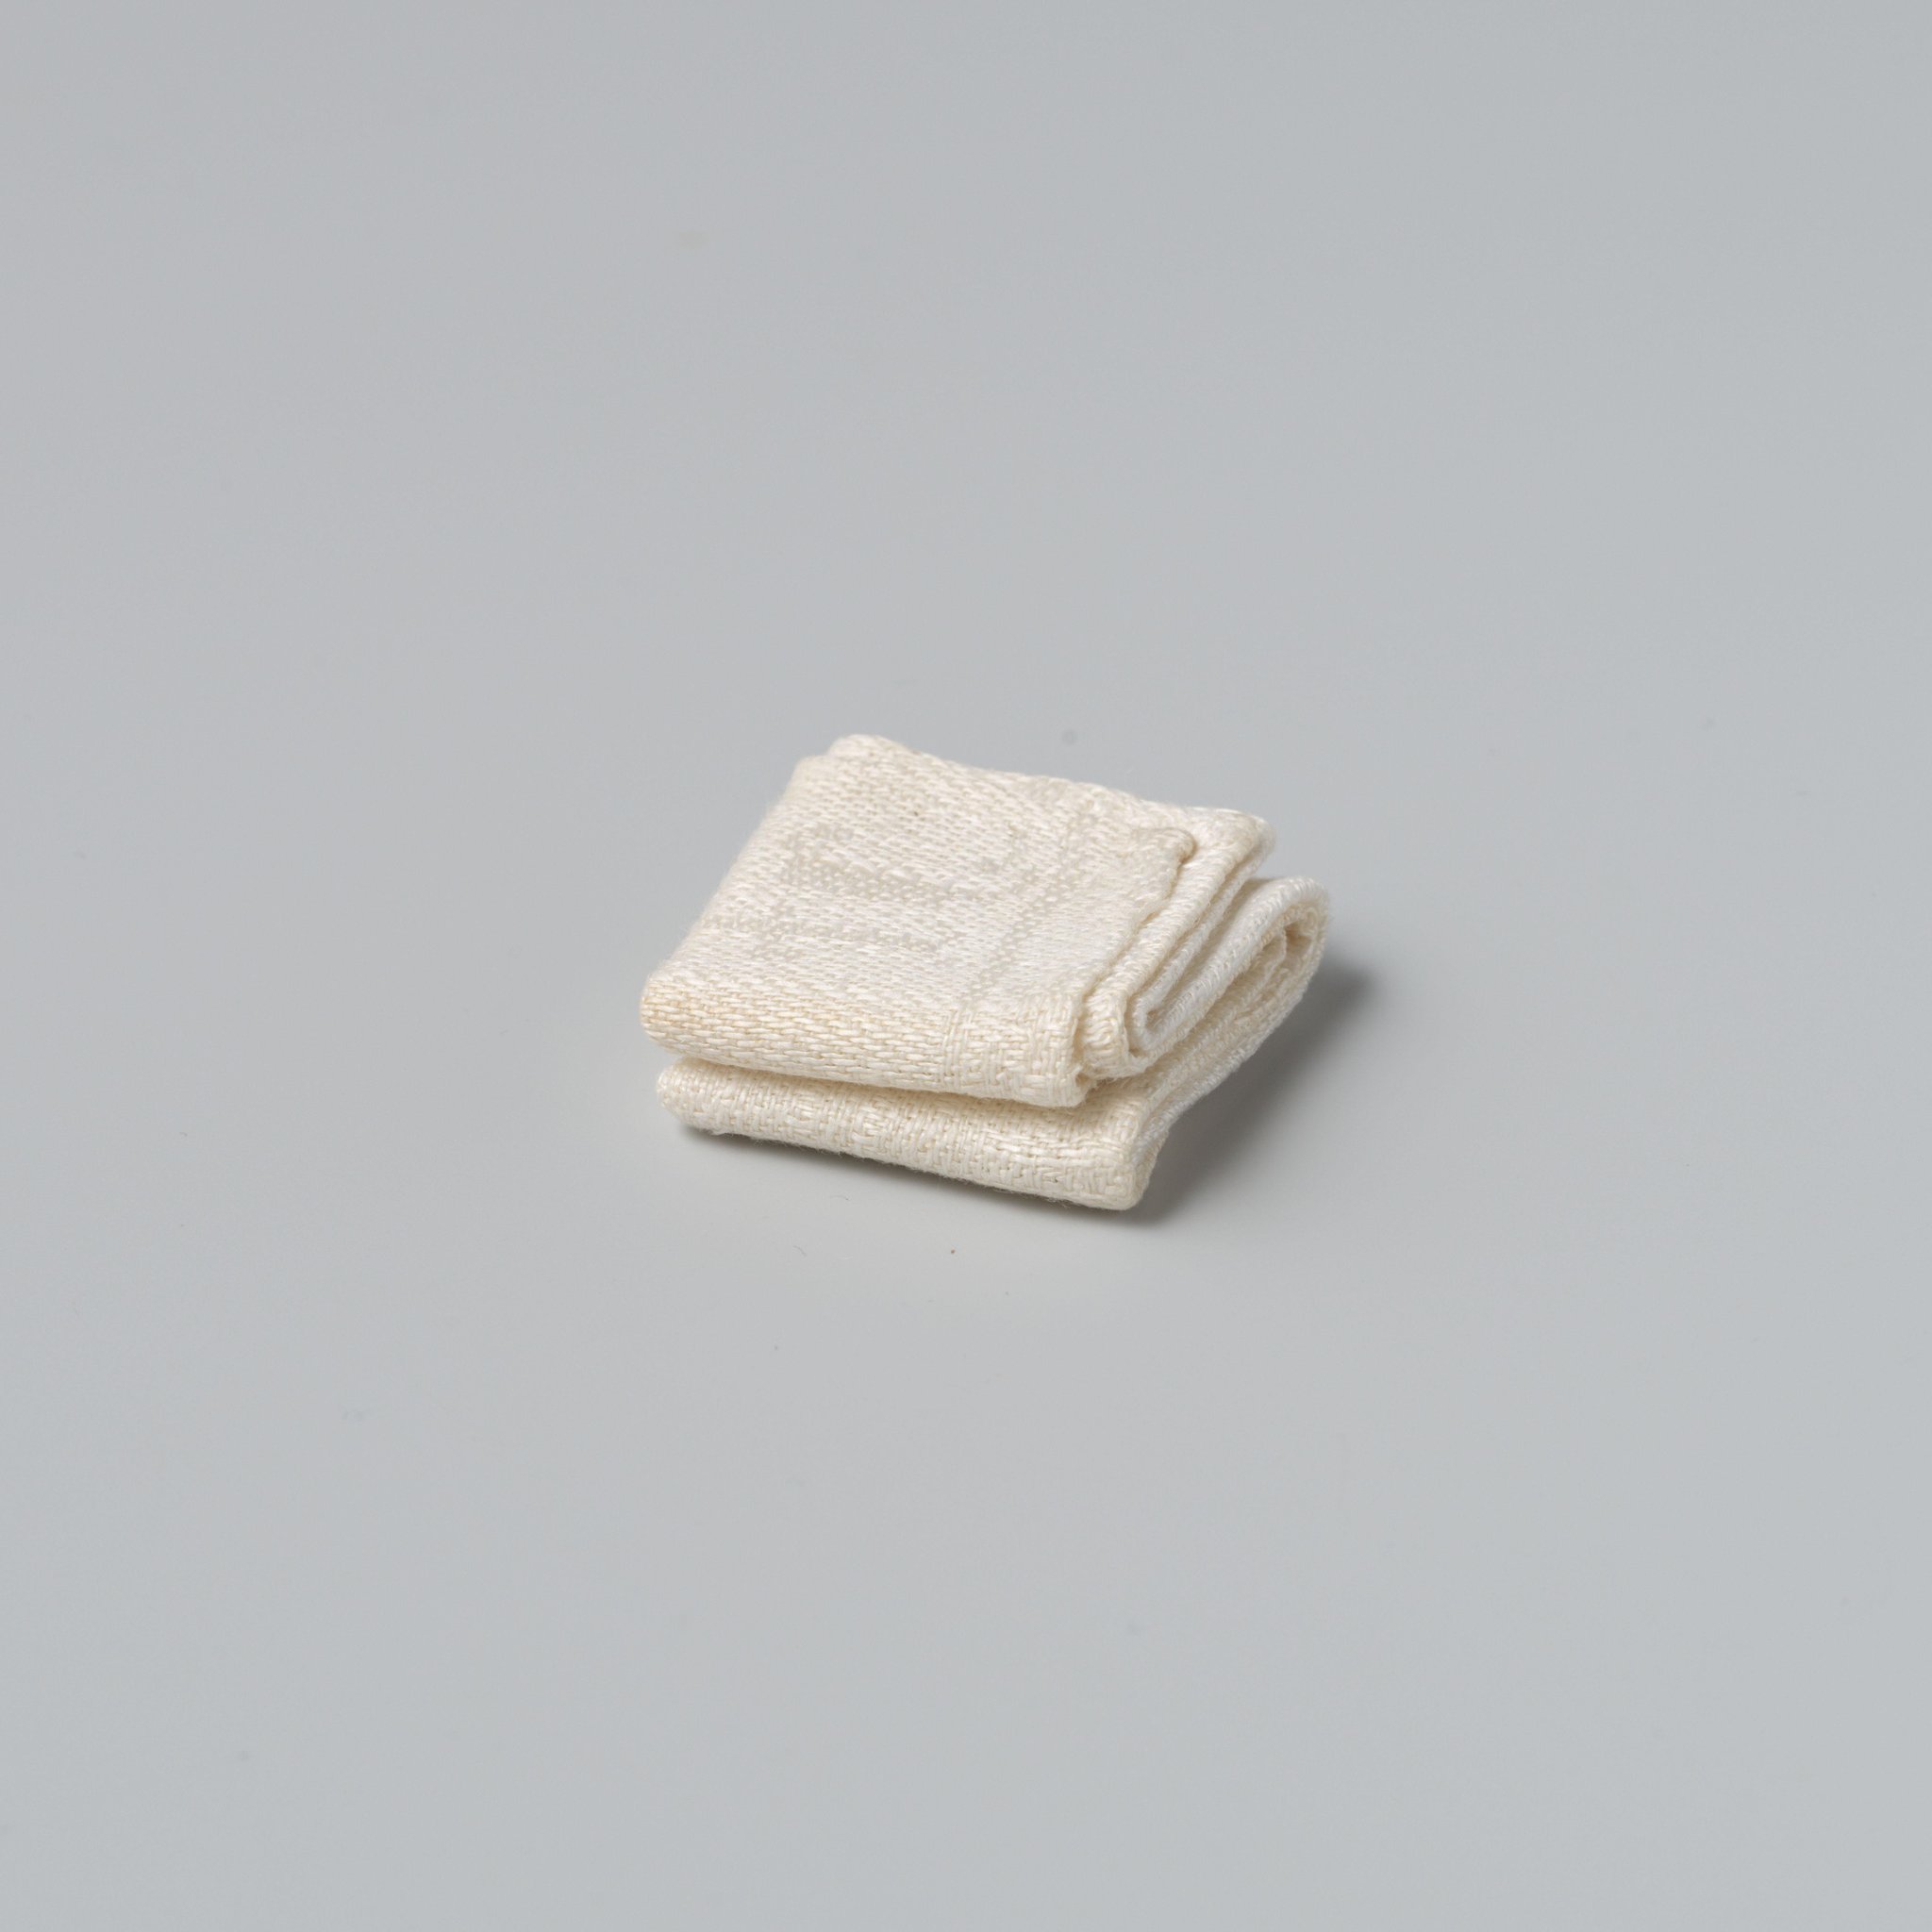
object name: napkin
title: Servet, linnendamast, met de tekst: 'c t', 'Malines' en gespiegeld: 'Ma'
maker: Anonymous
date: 1600-1650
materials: linen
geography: kortrijk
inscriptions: inscription: ‘Ma’, inscription: ‘Malines’, inscription: ‘c t’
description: Servet, vervaardigd van linnendamast, met de tekst: 'c t', 'Malines' en gespiegeld: 'Ma', geknipt uit een paar grotere servetten of lopers met '17 provinciënpatroon'. Het servet is aan alle zijden omzoomd met een smalle rolzoom.